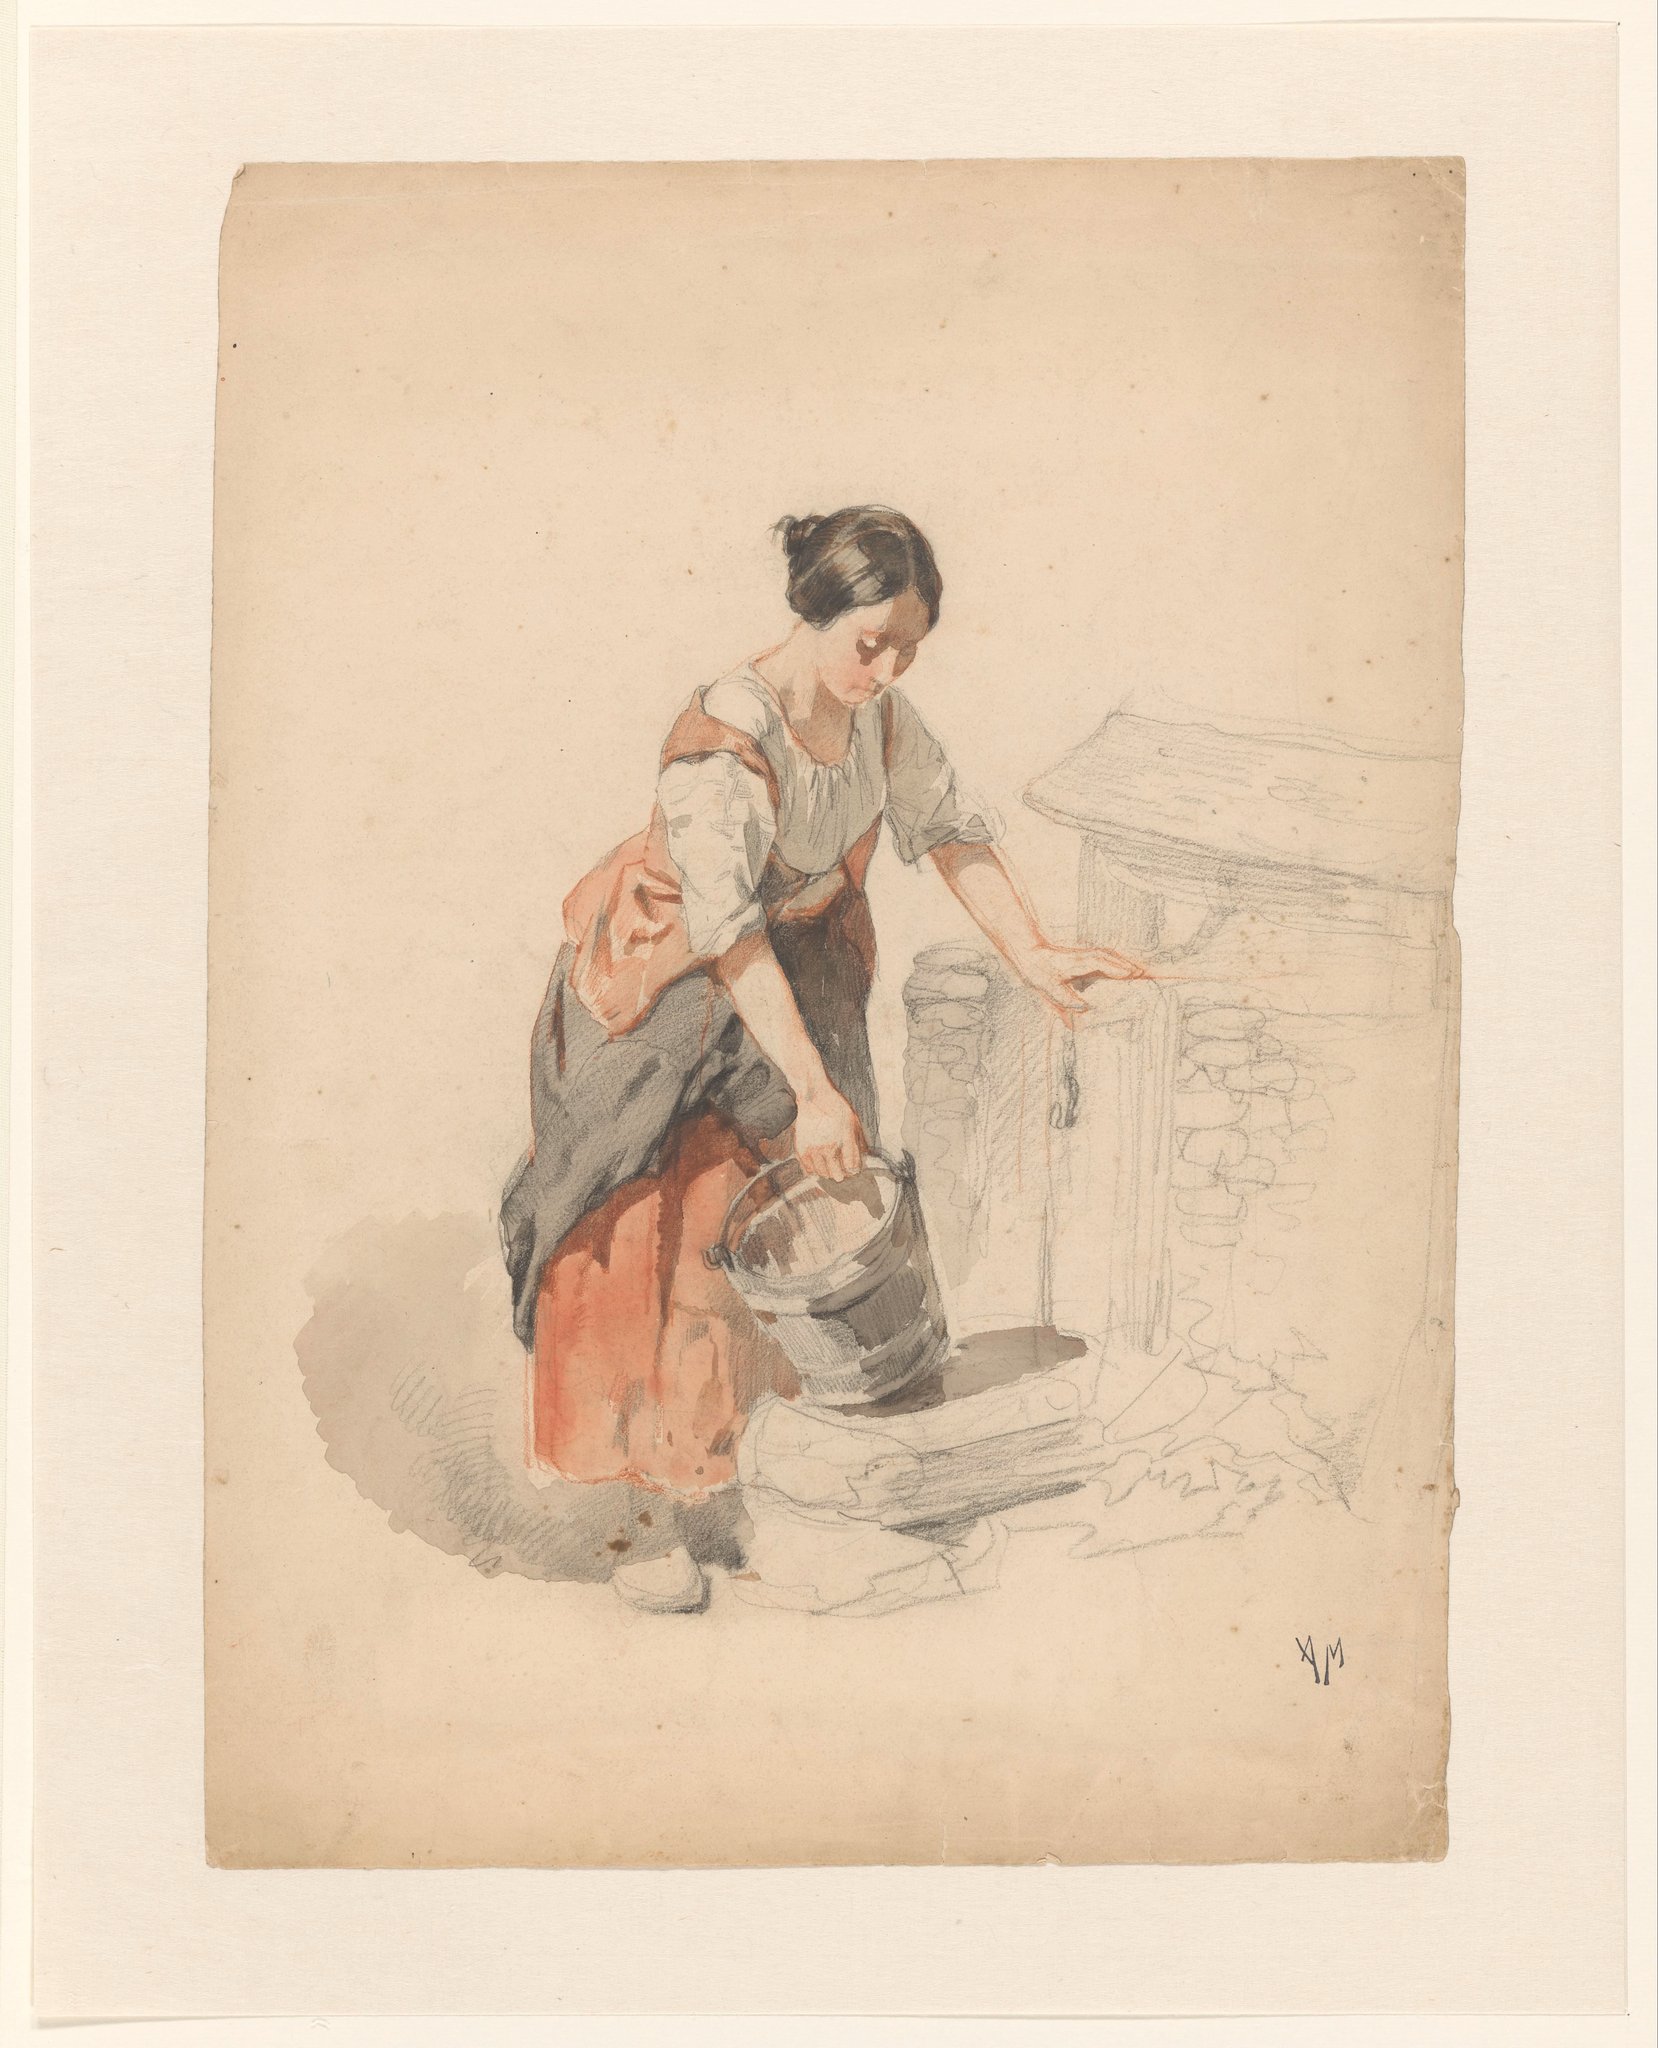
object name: drawing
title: Jonge vrouw die een emmer vult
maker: anton mauve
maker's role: draughtsman, painter, print maker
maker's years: 1838-1888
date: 1848-1888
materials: chalk, paper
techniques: brush